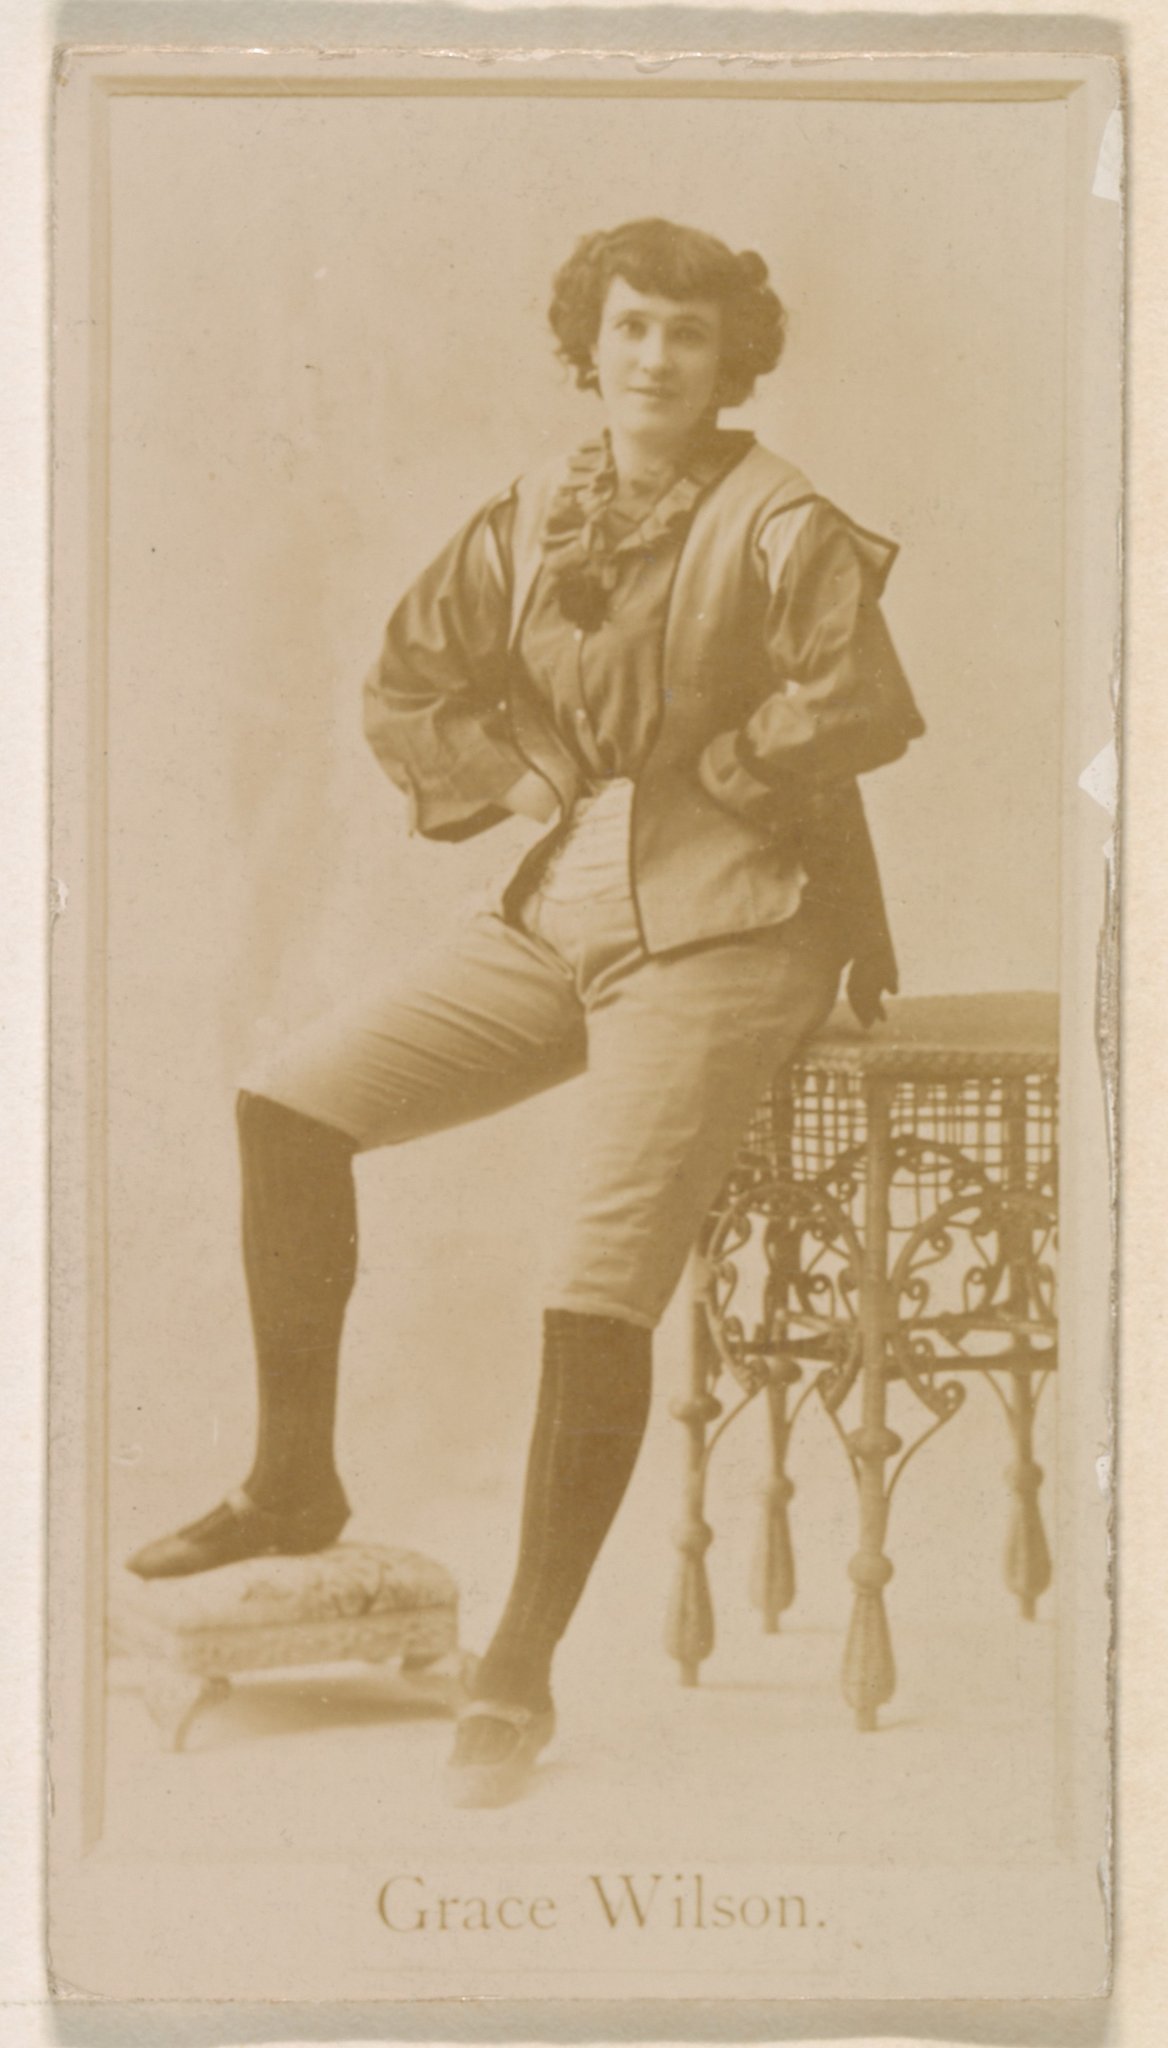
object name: photograph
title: Grace Wilson, from the Actresses series (N245) issued by Kinney Brothers to promote Sweet Caporal Cigarettes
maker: kinney brothers tobacco company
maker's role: publisher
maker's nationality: american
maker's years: 1869-2011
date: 1890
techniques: albumen silver print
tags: portraits,women,actresses